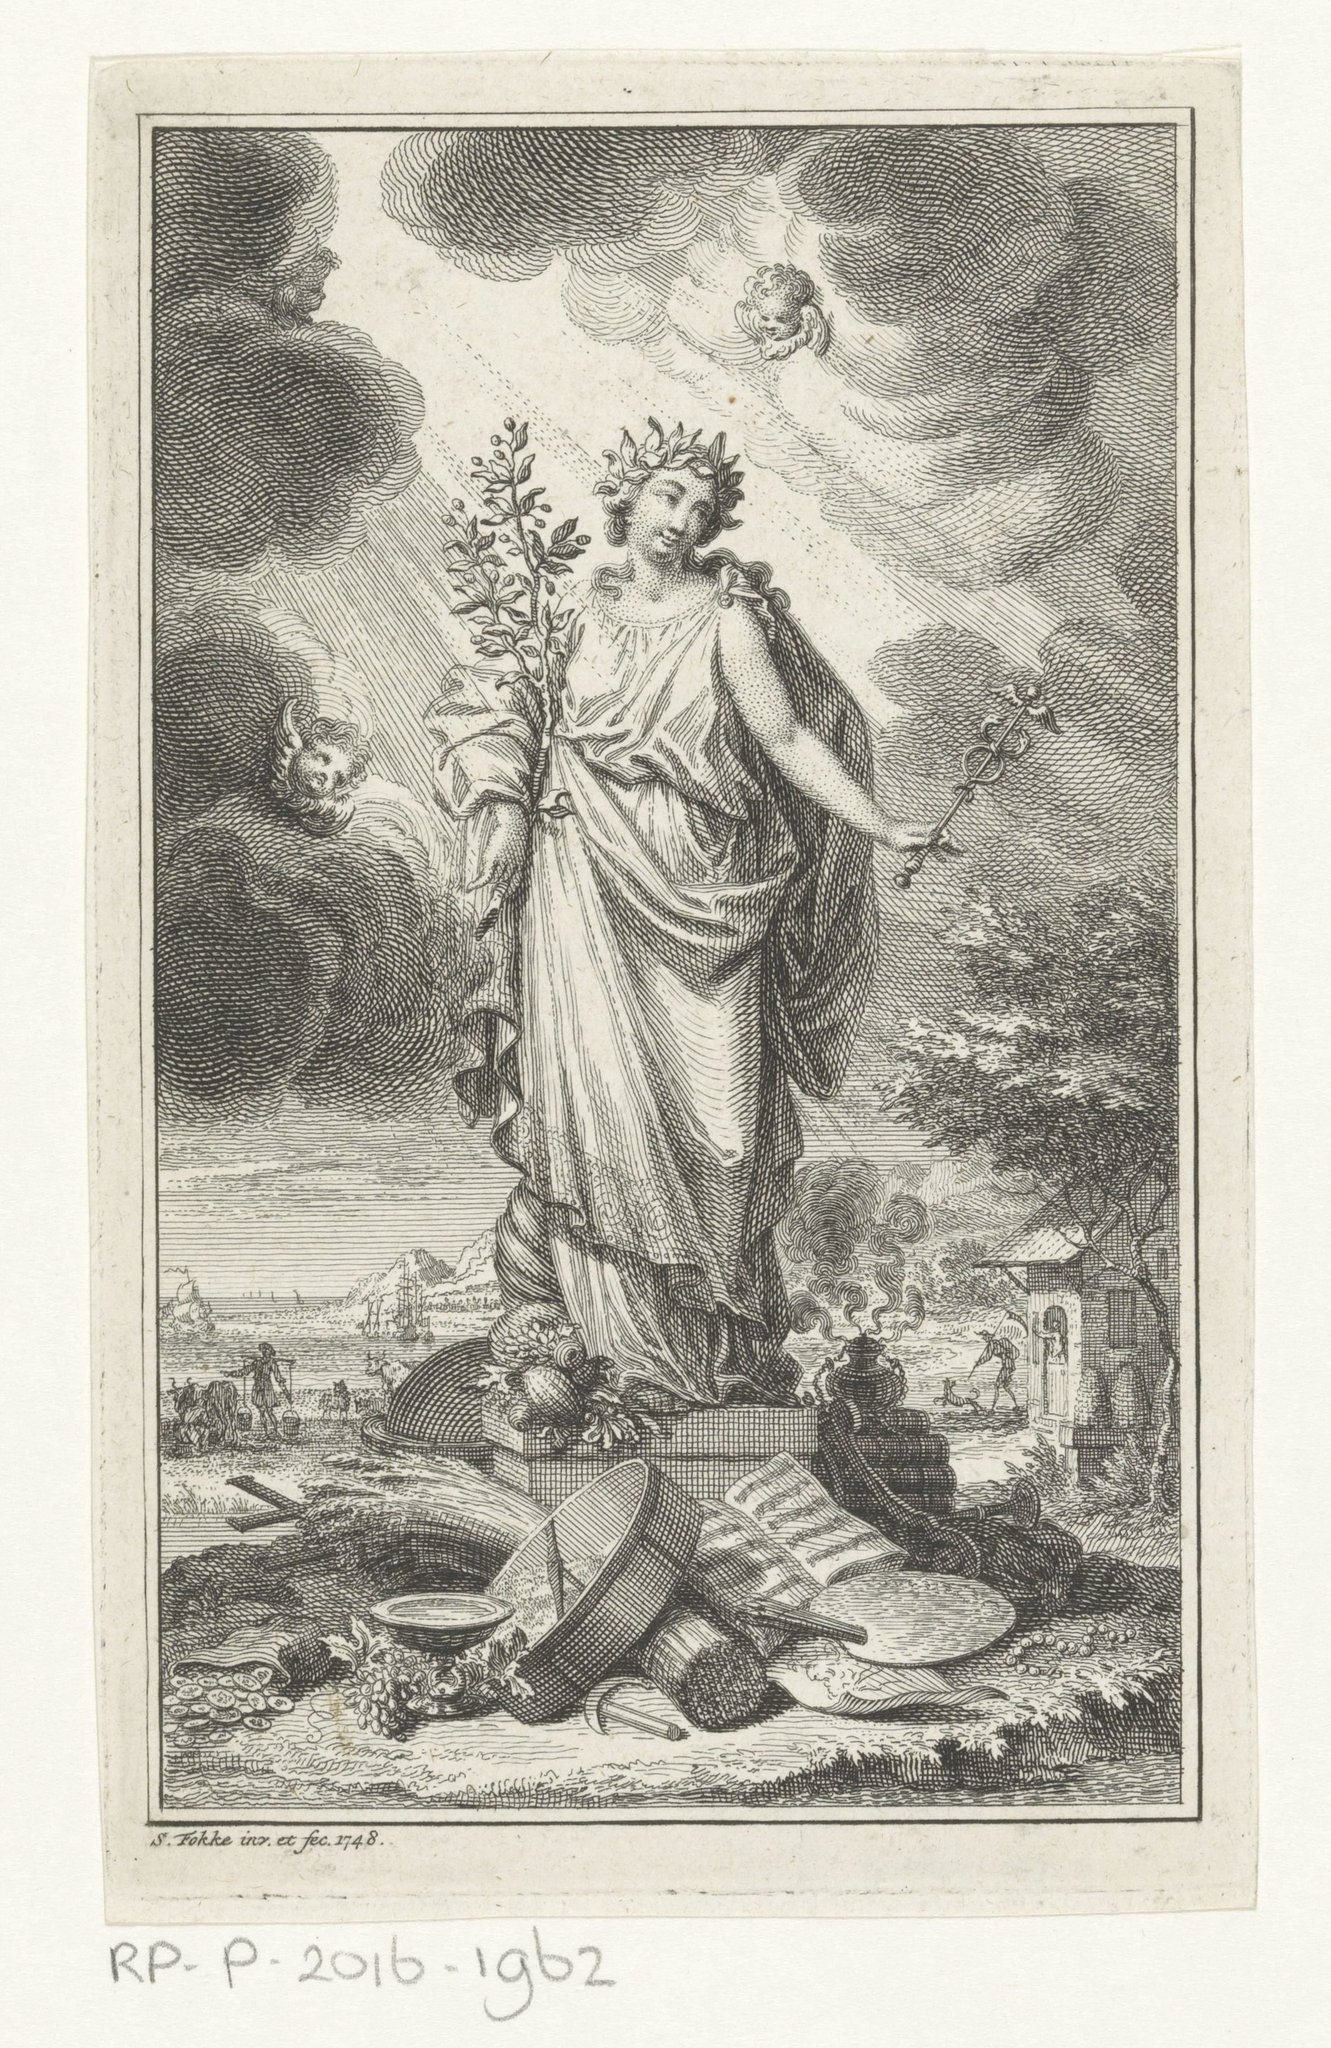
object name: print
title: Vrede met caduceus en olijftak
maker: simon fokke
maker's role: draughtsman, print maker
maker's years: 1712-1784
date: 1748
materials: paper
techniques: engraving, etching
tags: agreement, unity; 'concordia', 'concordia insuperabile', 'concordia militare', 'concordia di pace', 'unione civile' (ripa), welfare, prosperity; 'felicità publica', 'prosperità della vita', 'salute' (ripa), peace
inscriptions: collector's mark: Lugt 2228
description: Op een voetstuk staat de gelauwerde personificatie van de vrede met een caduceus en olijftak in haar handen. Voor haar op de grond liggen een zak geld, schilderspalet met penselen, een bundel koren, vruchten en bladmuziek: attributen die wijzen op eendracht en welvaart.